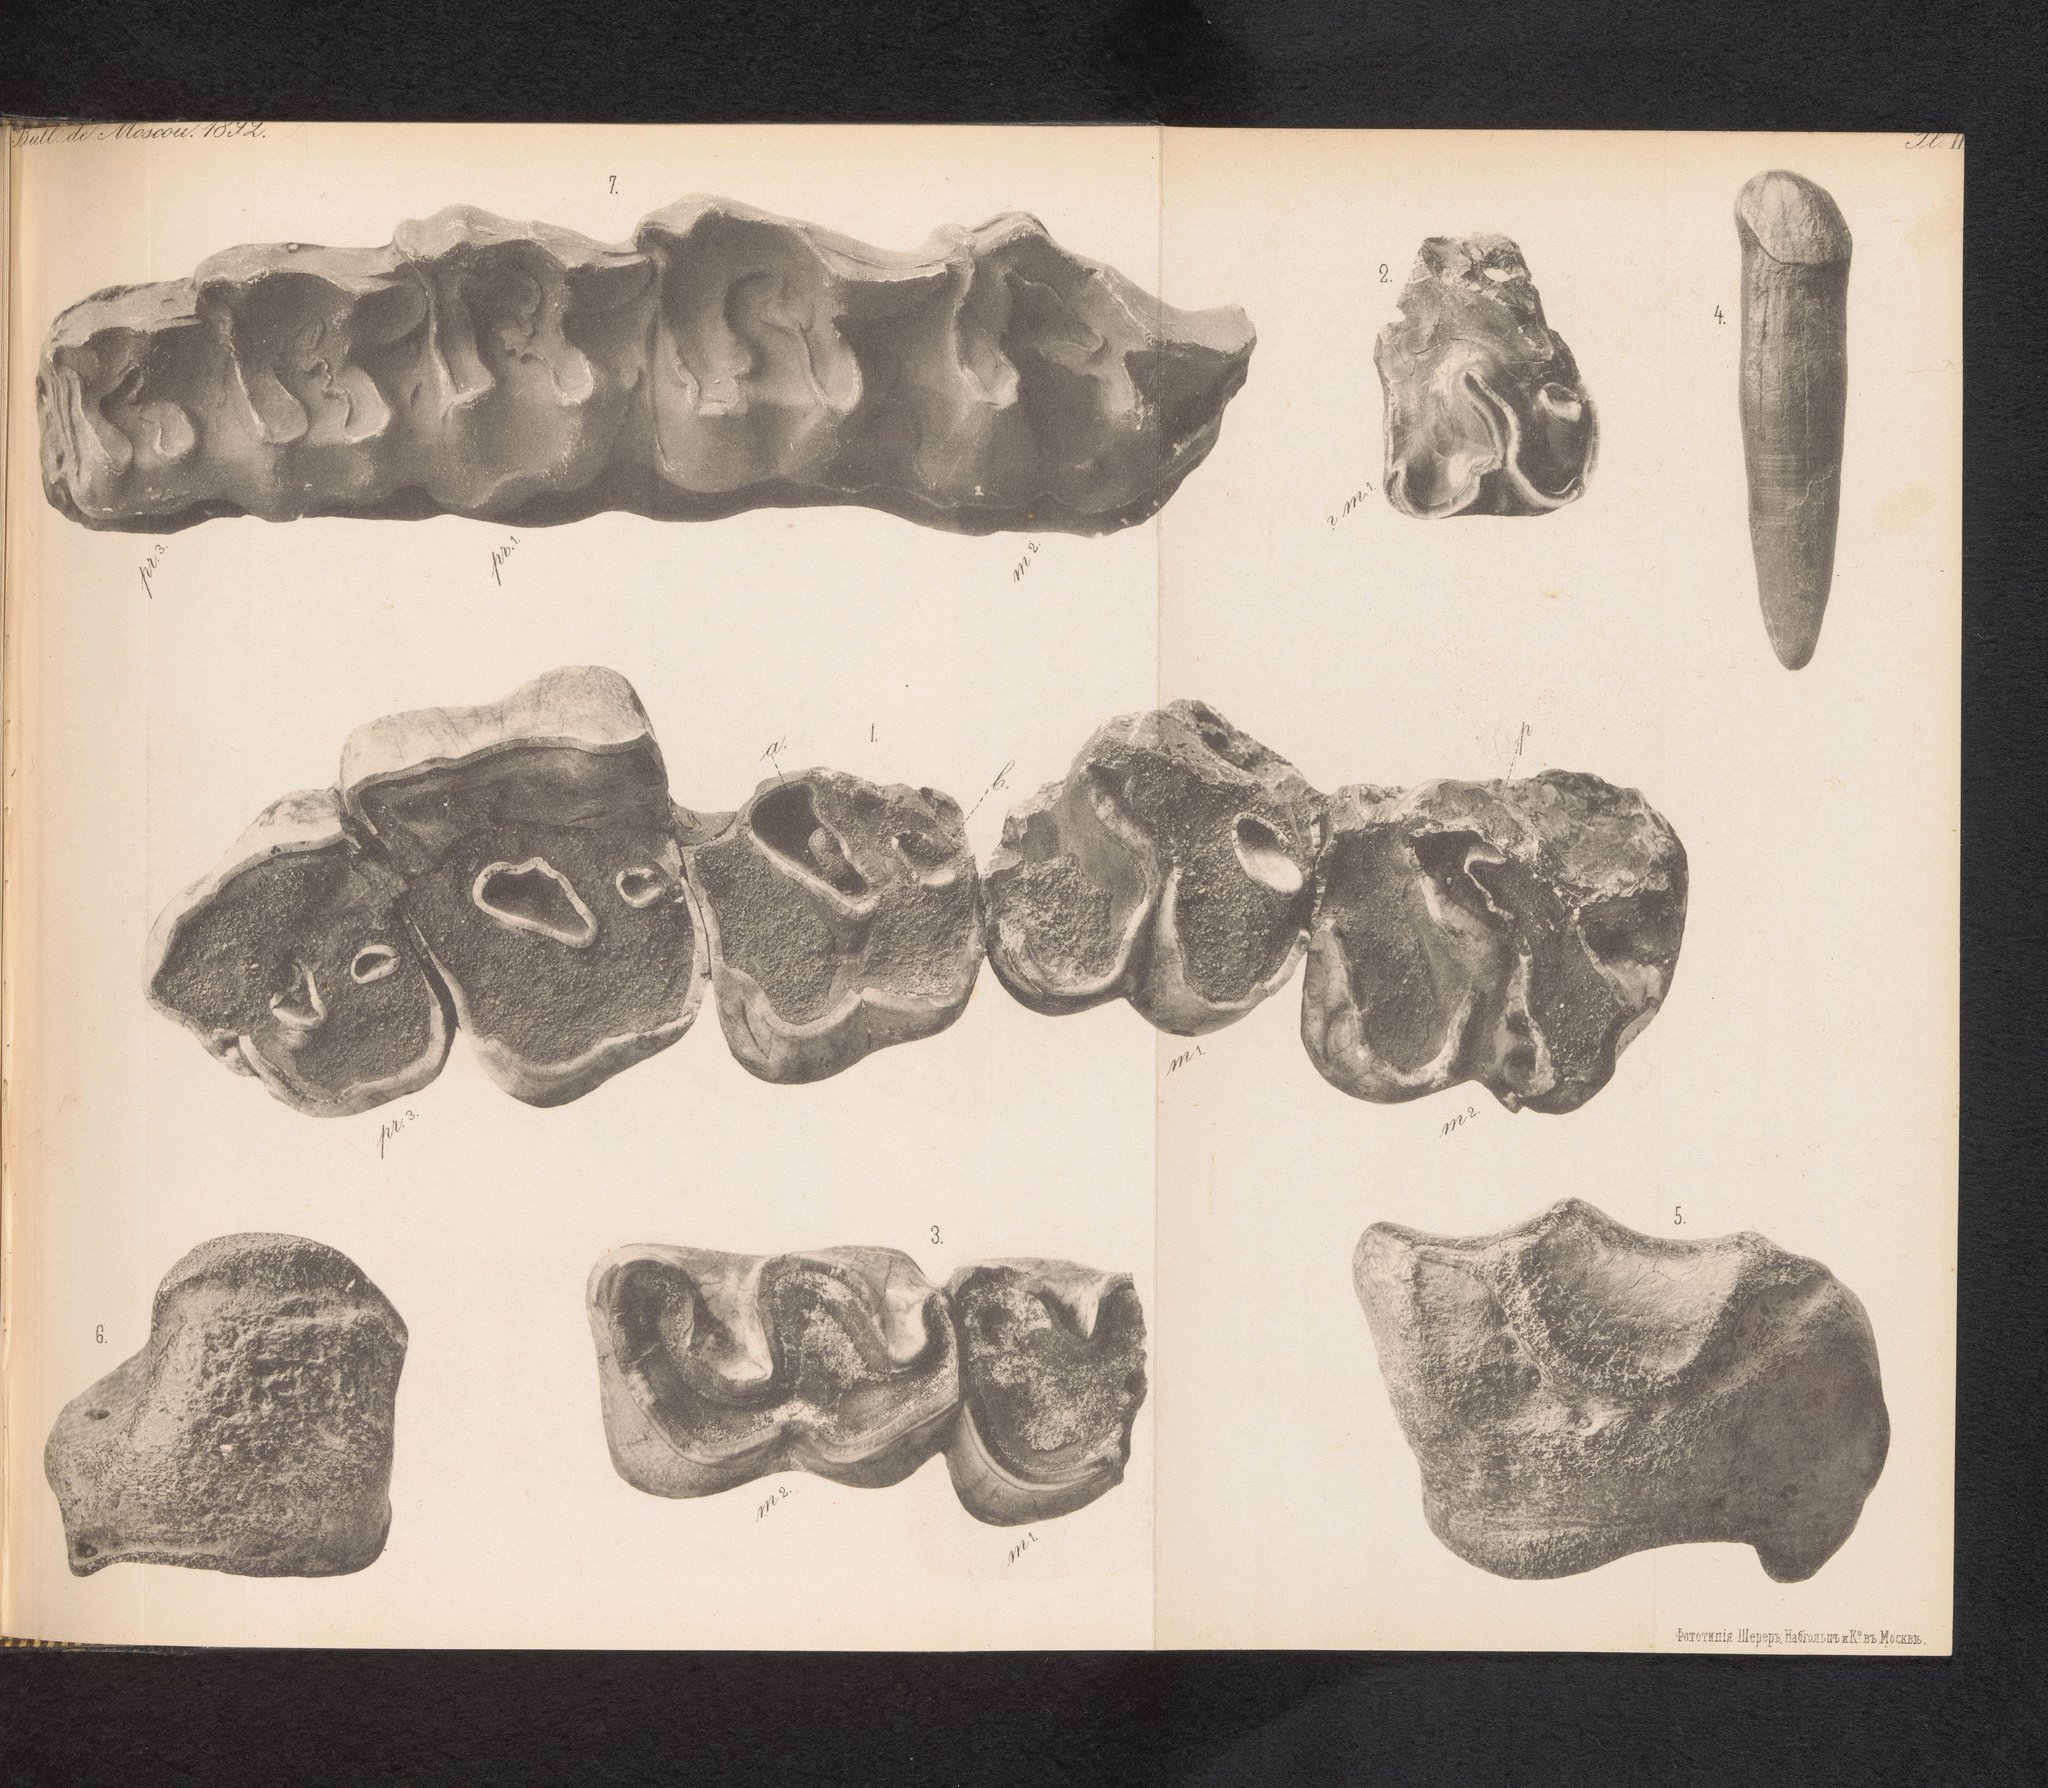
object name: photomechanical print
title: Zeven delen van het gebit van verschillende soorten neushoorns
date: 1888-1893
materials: paper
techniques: photoaquatint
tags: hoofed animals: rhinoceros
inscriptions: number: ‘1/ 2/ 3/ 4/ 5/ 6/ 7’